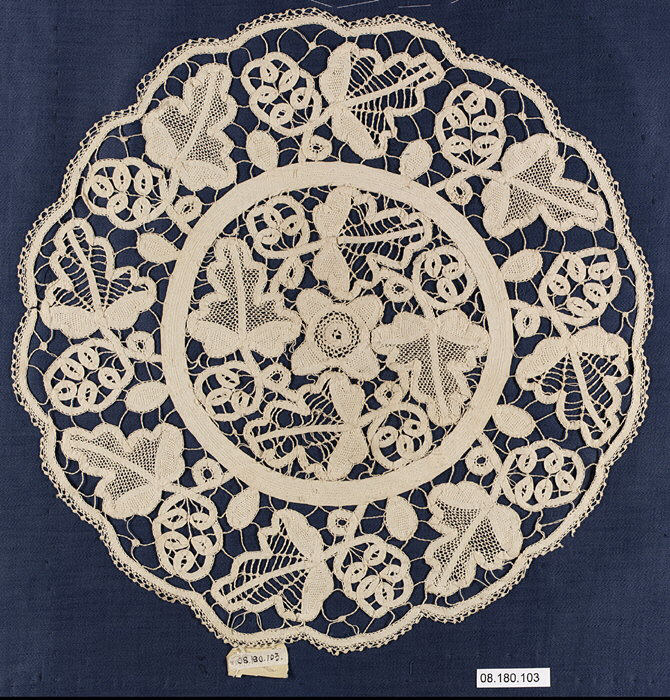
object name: mat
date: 1801-1900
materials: lace